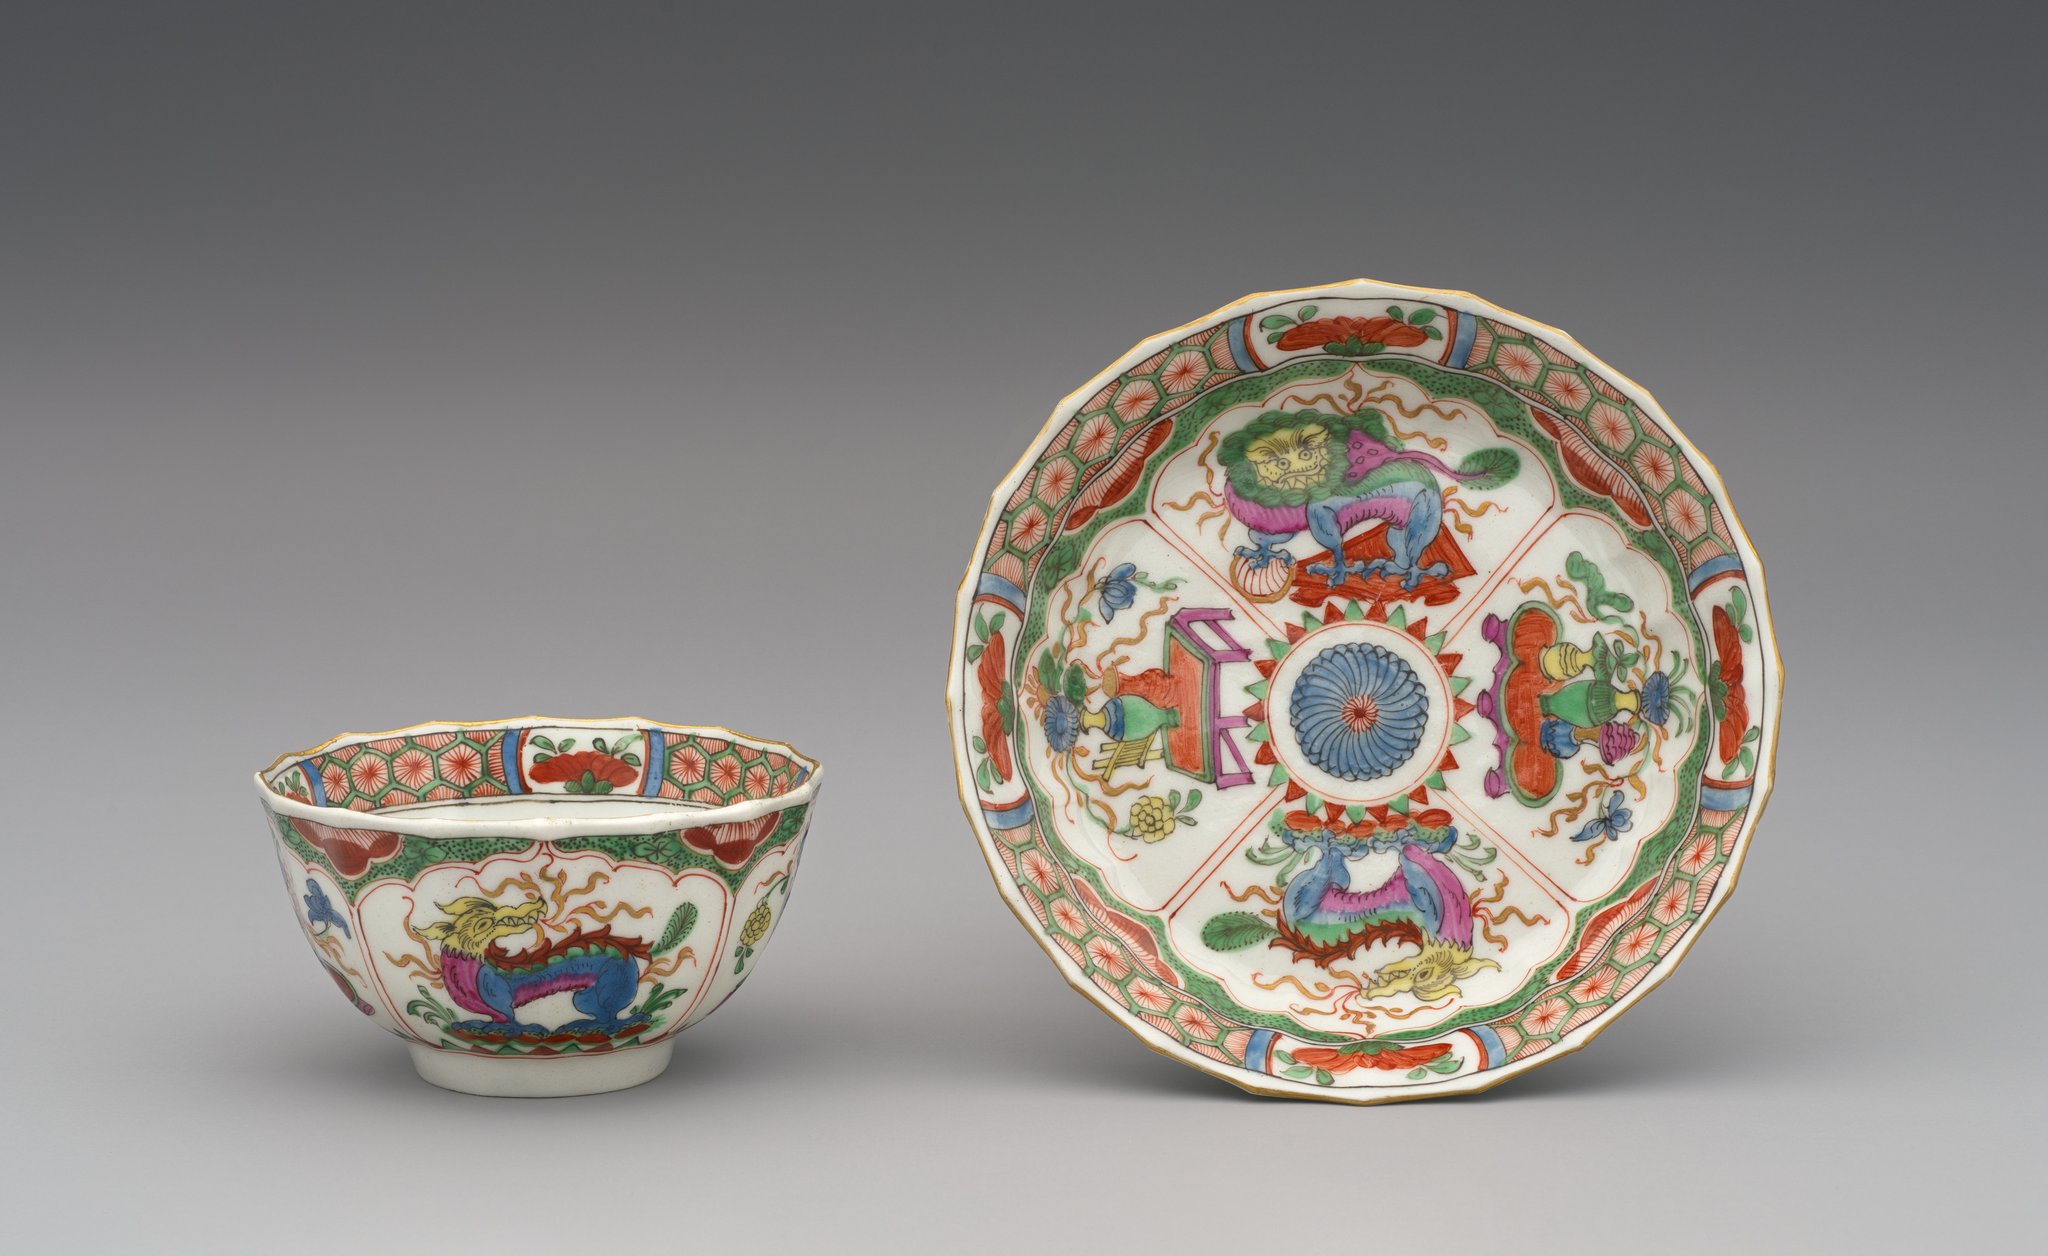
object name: cup and saucer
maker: worcester factory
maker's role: factory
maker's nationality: british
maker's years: 1751-2008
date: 1770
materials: soft paste porcelain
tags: lions